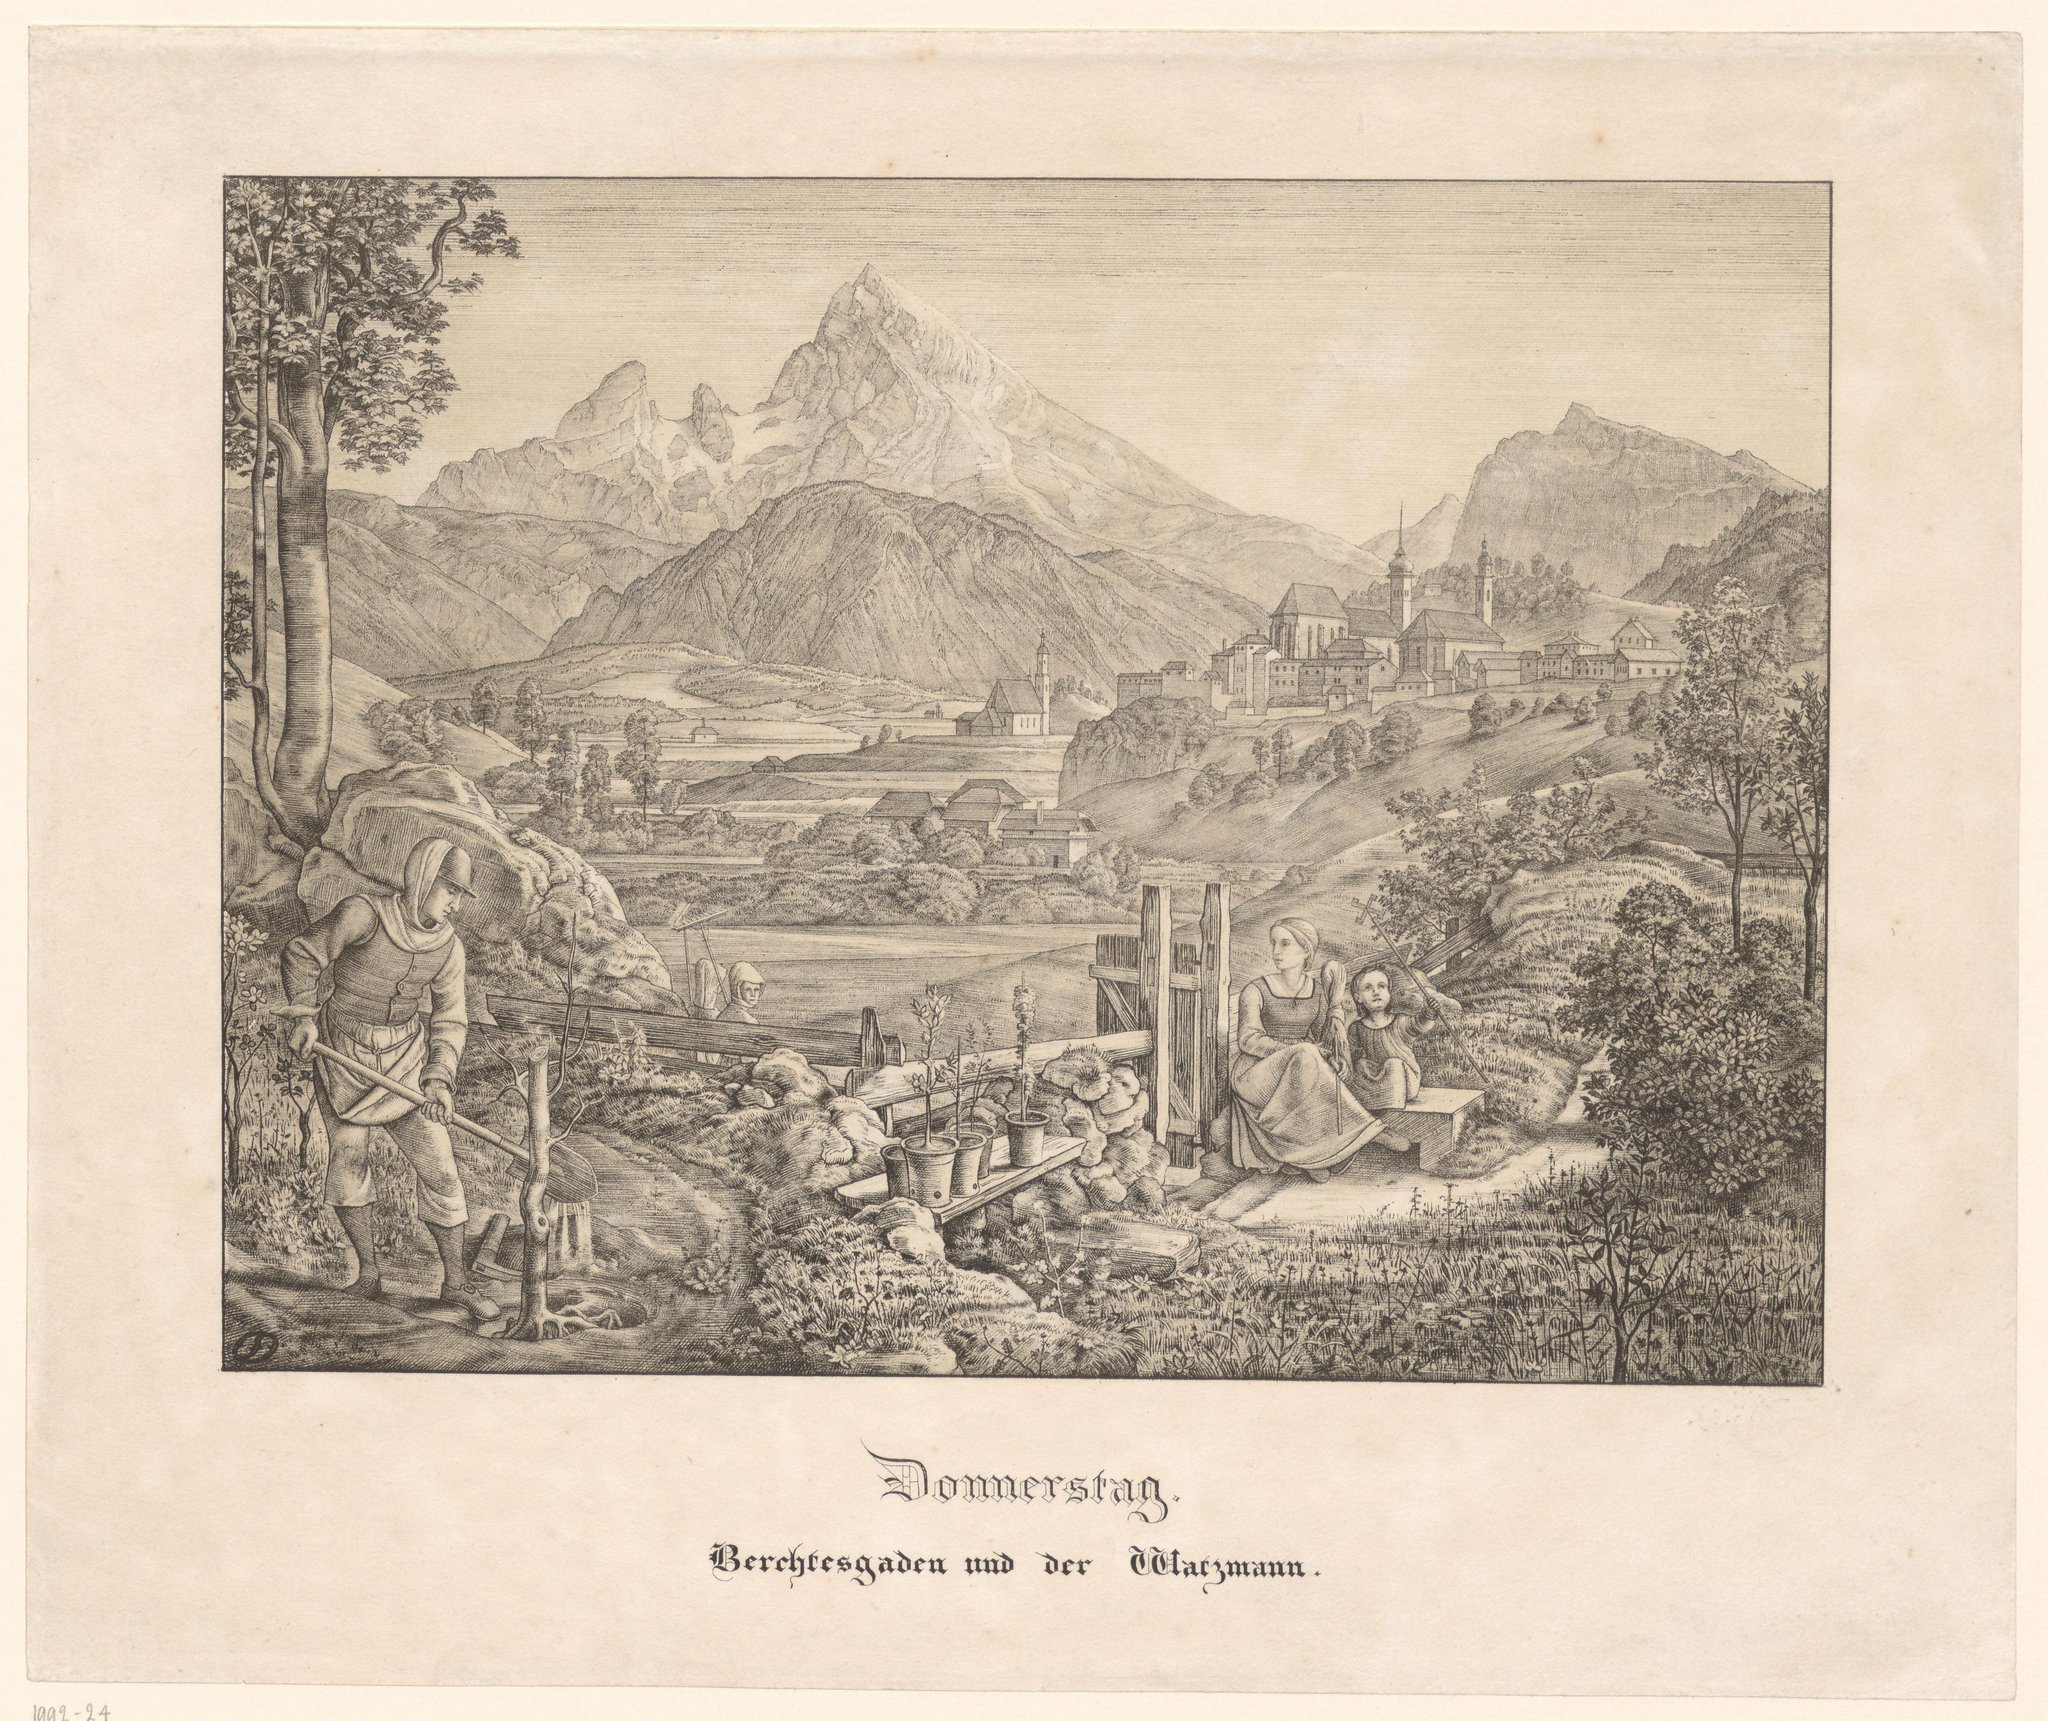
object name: print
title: Gebieden in Salzburg en Berchtesgaden, gesorteerd naar de zeven dagen van de week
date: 1823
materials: paper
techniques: lithograph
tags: days of the week, landscapes in the temperate zone (+ landscape with figures, staffage), mountains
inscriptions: monogram: ‘FO.’, collector's mark: Lugt 2760, collector's mark: Lugt 2228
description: Gezicht, van Salzburg af gezien, op Berchtesgaden en het woeste Watzmannmassief, dat boven de Grünstein oprijst. Op de voorgrond een landman bezig in zijn tuin en een vrouw en een kind kijken toe.